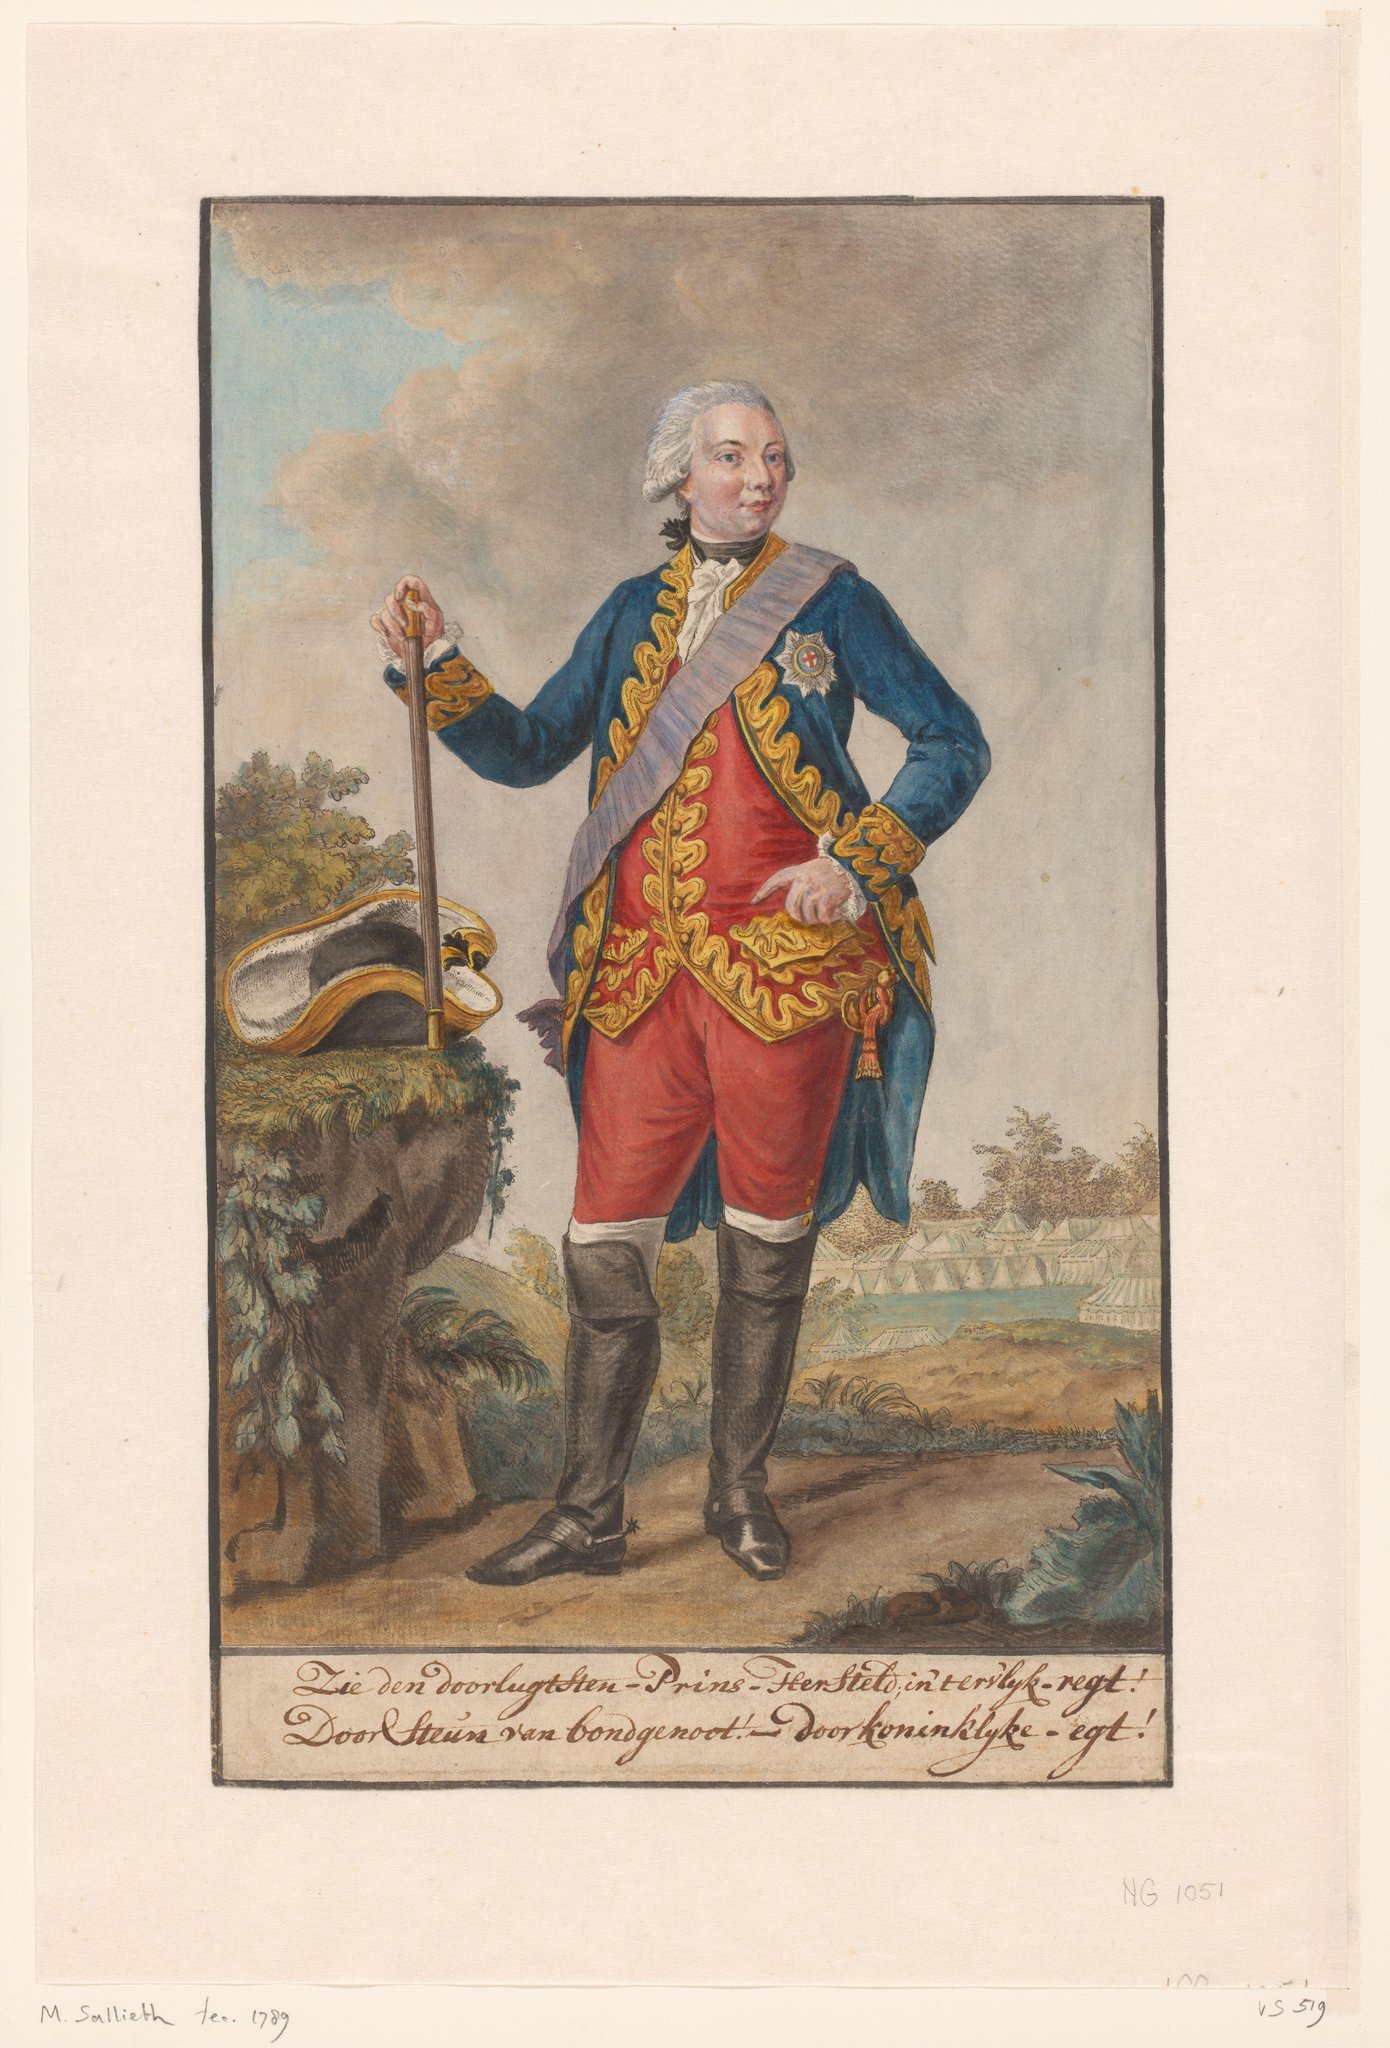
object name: print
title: Portret van Willem V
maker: mathias de sallieth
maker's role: print maker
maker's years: 1749-1791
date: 1789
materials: paper, watercolor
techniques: etching, hand coloring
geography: netherlands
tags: the hague, william v (prince of orange), (military) camp with tents, historical persons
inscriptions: inscription: ‘Zie den doorlugtsten - Prins - Hersteld, in 't erv'lijk regt! / Door Steun van bondgenoot! - door koninklijke egt!'’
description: Ingekleurde prent met een portret van stadhouder Willem V, staande ten voeten uit, in uniform, commandostaf in rechterhand leunend op een rots, waarop zijn hoed ligt. Op de achtergrond een tentenkamp.